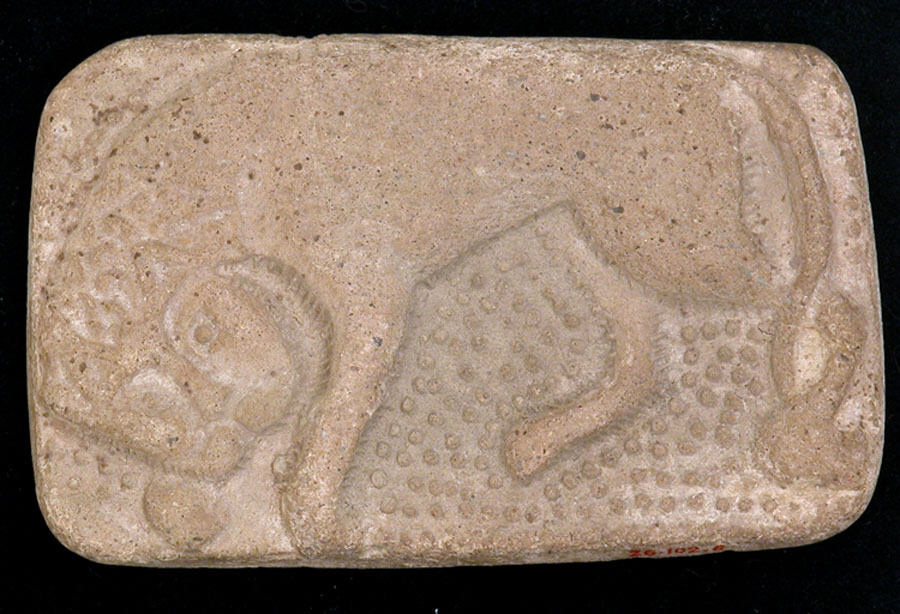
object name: bath scraper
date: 1101-1300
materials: earthenware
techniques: molding, relief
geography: iran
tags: animals